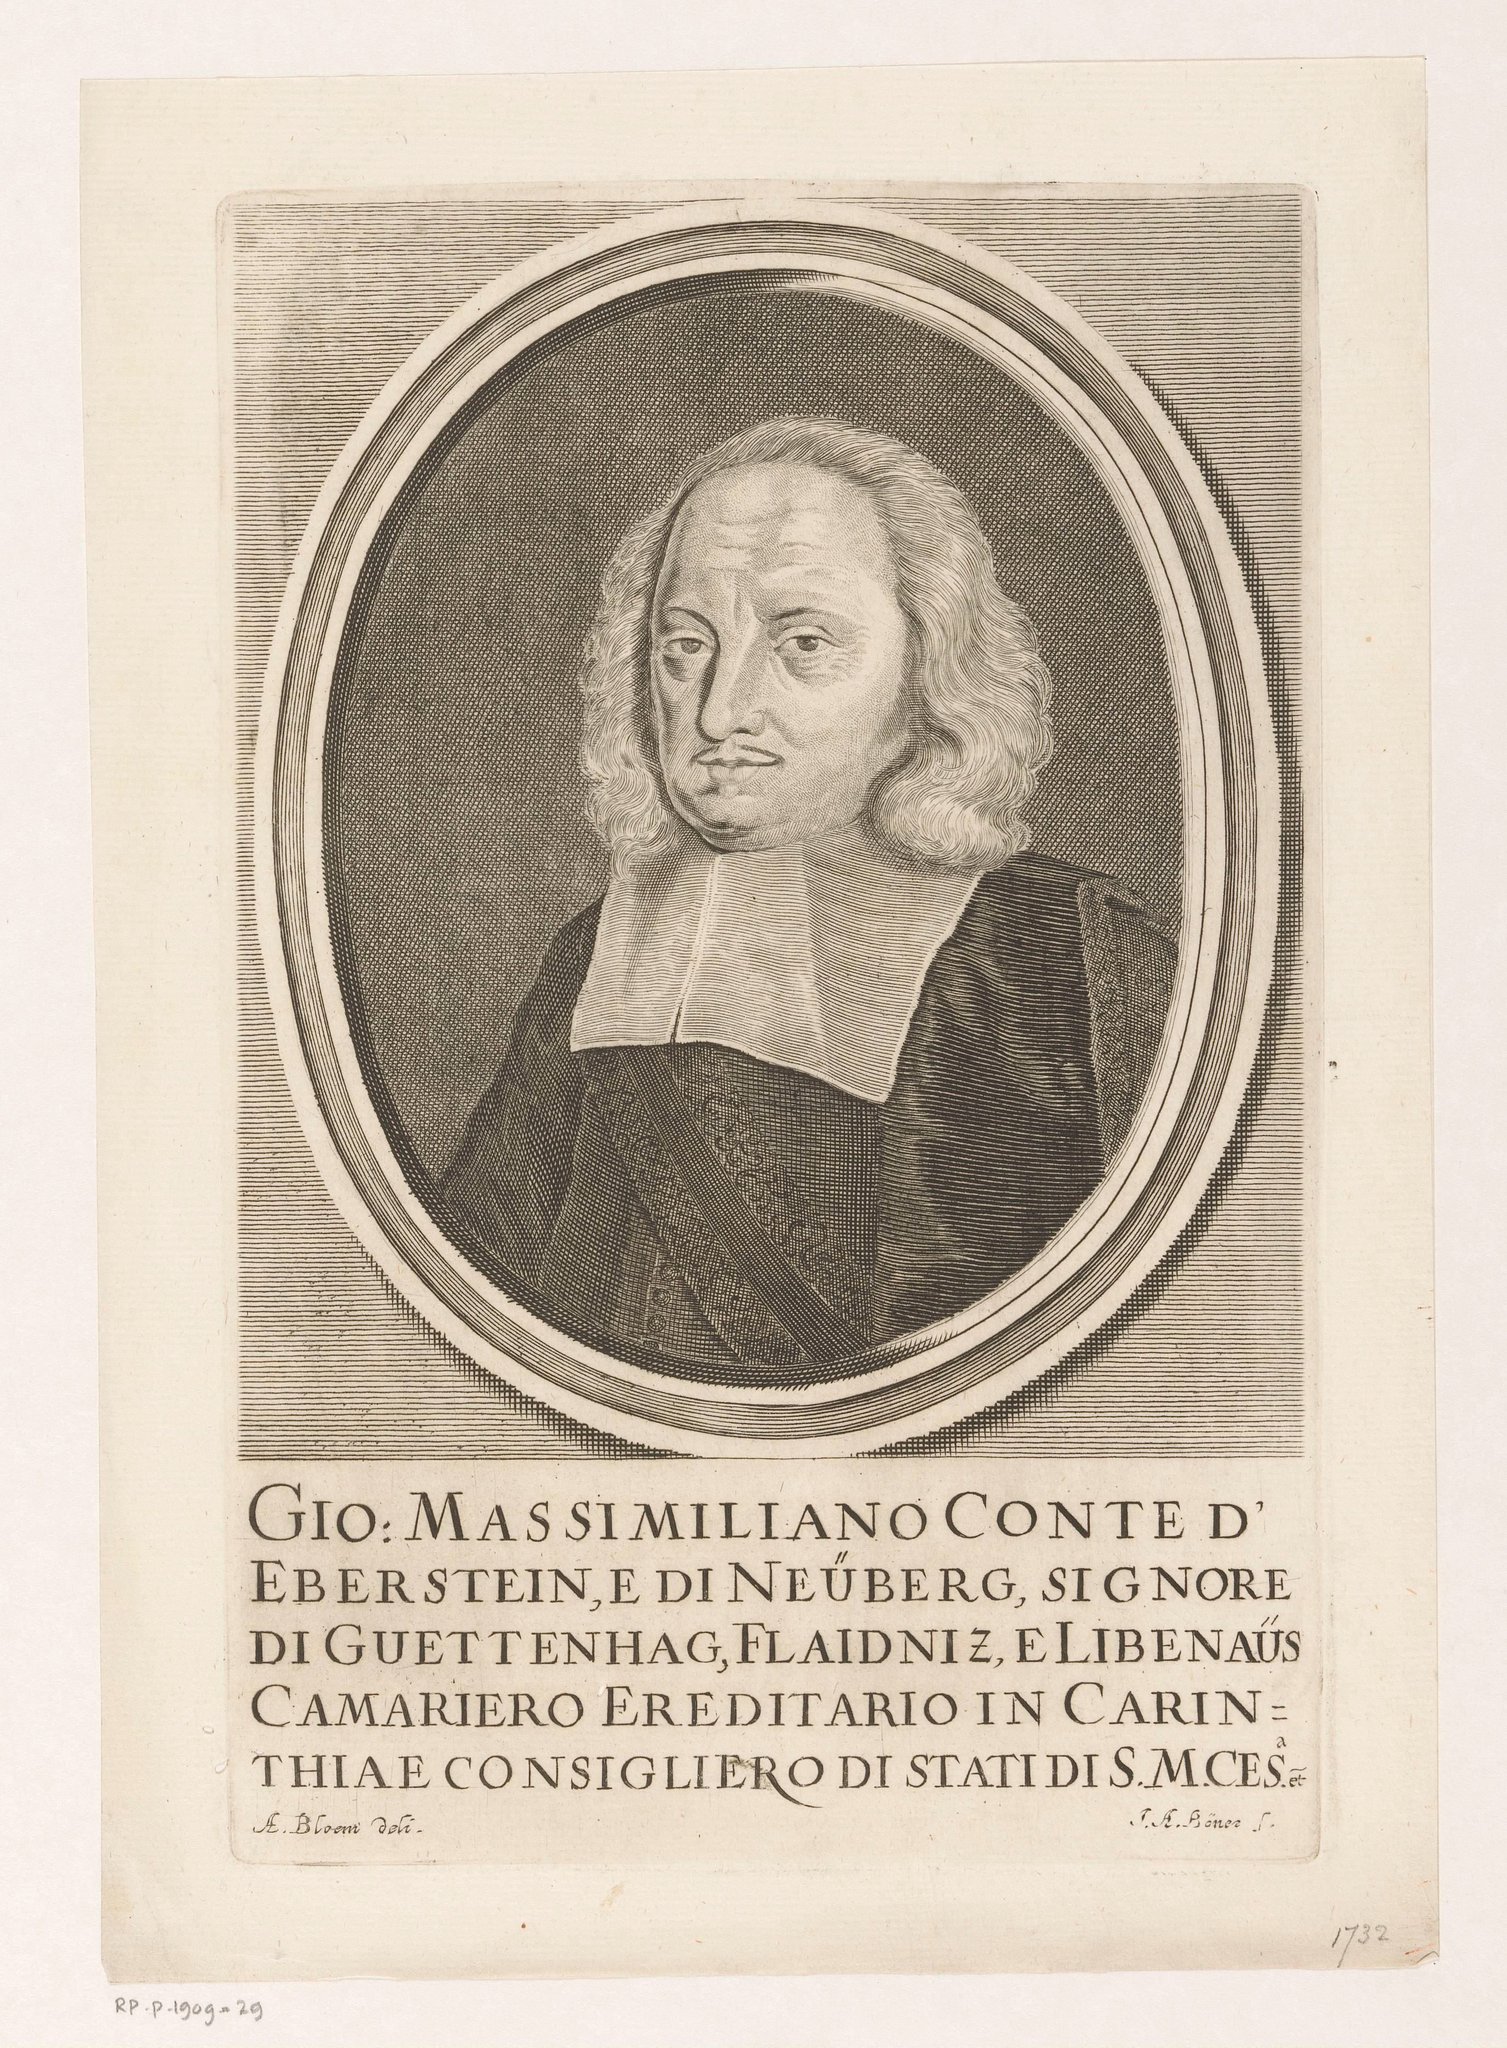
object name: print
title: Portret van Johann Maximilian, Graf von Welz auf Eberstein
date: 1674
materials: paper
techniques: engraving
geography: nuremberg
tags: historical persons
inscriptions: collector's mark: Lugt 2228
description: Prent ook gebruikt in: Gualdo Priorato, Galeazzo. Historia di Leopoldo Cesare. 3 dln. Wenen: Johann Baptist Hacque, 1670-1674, dl. 3 [1674], na p. 70.